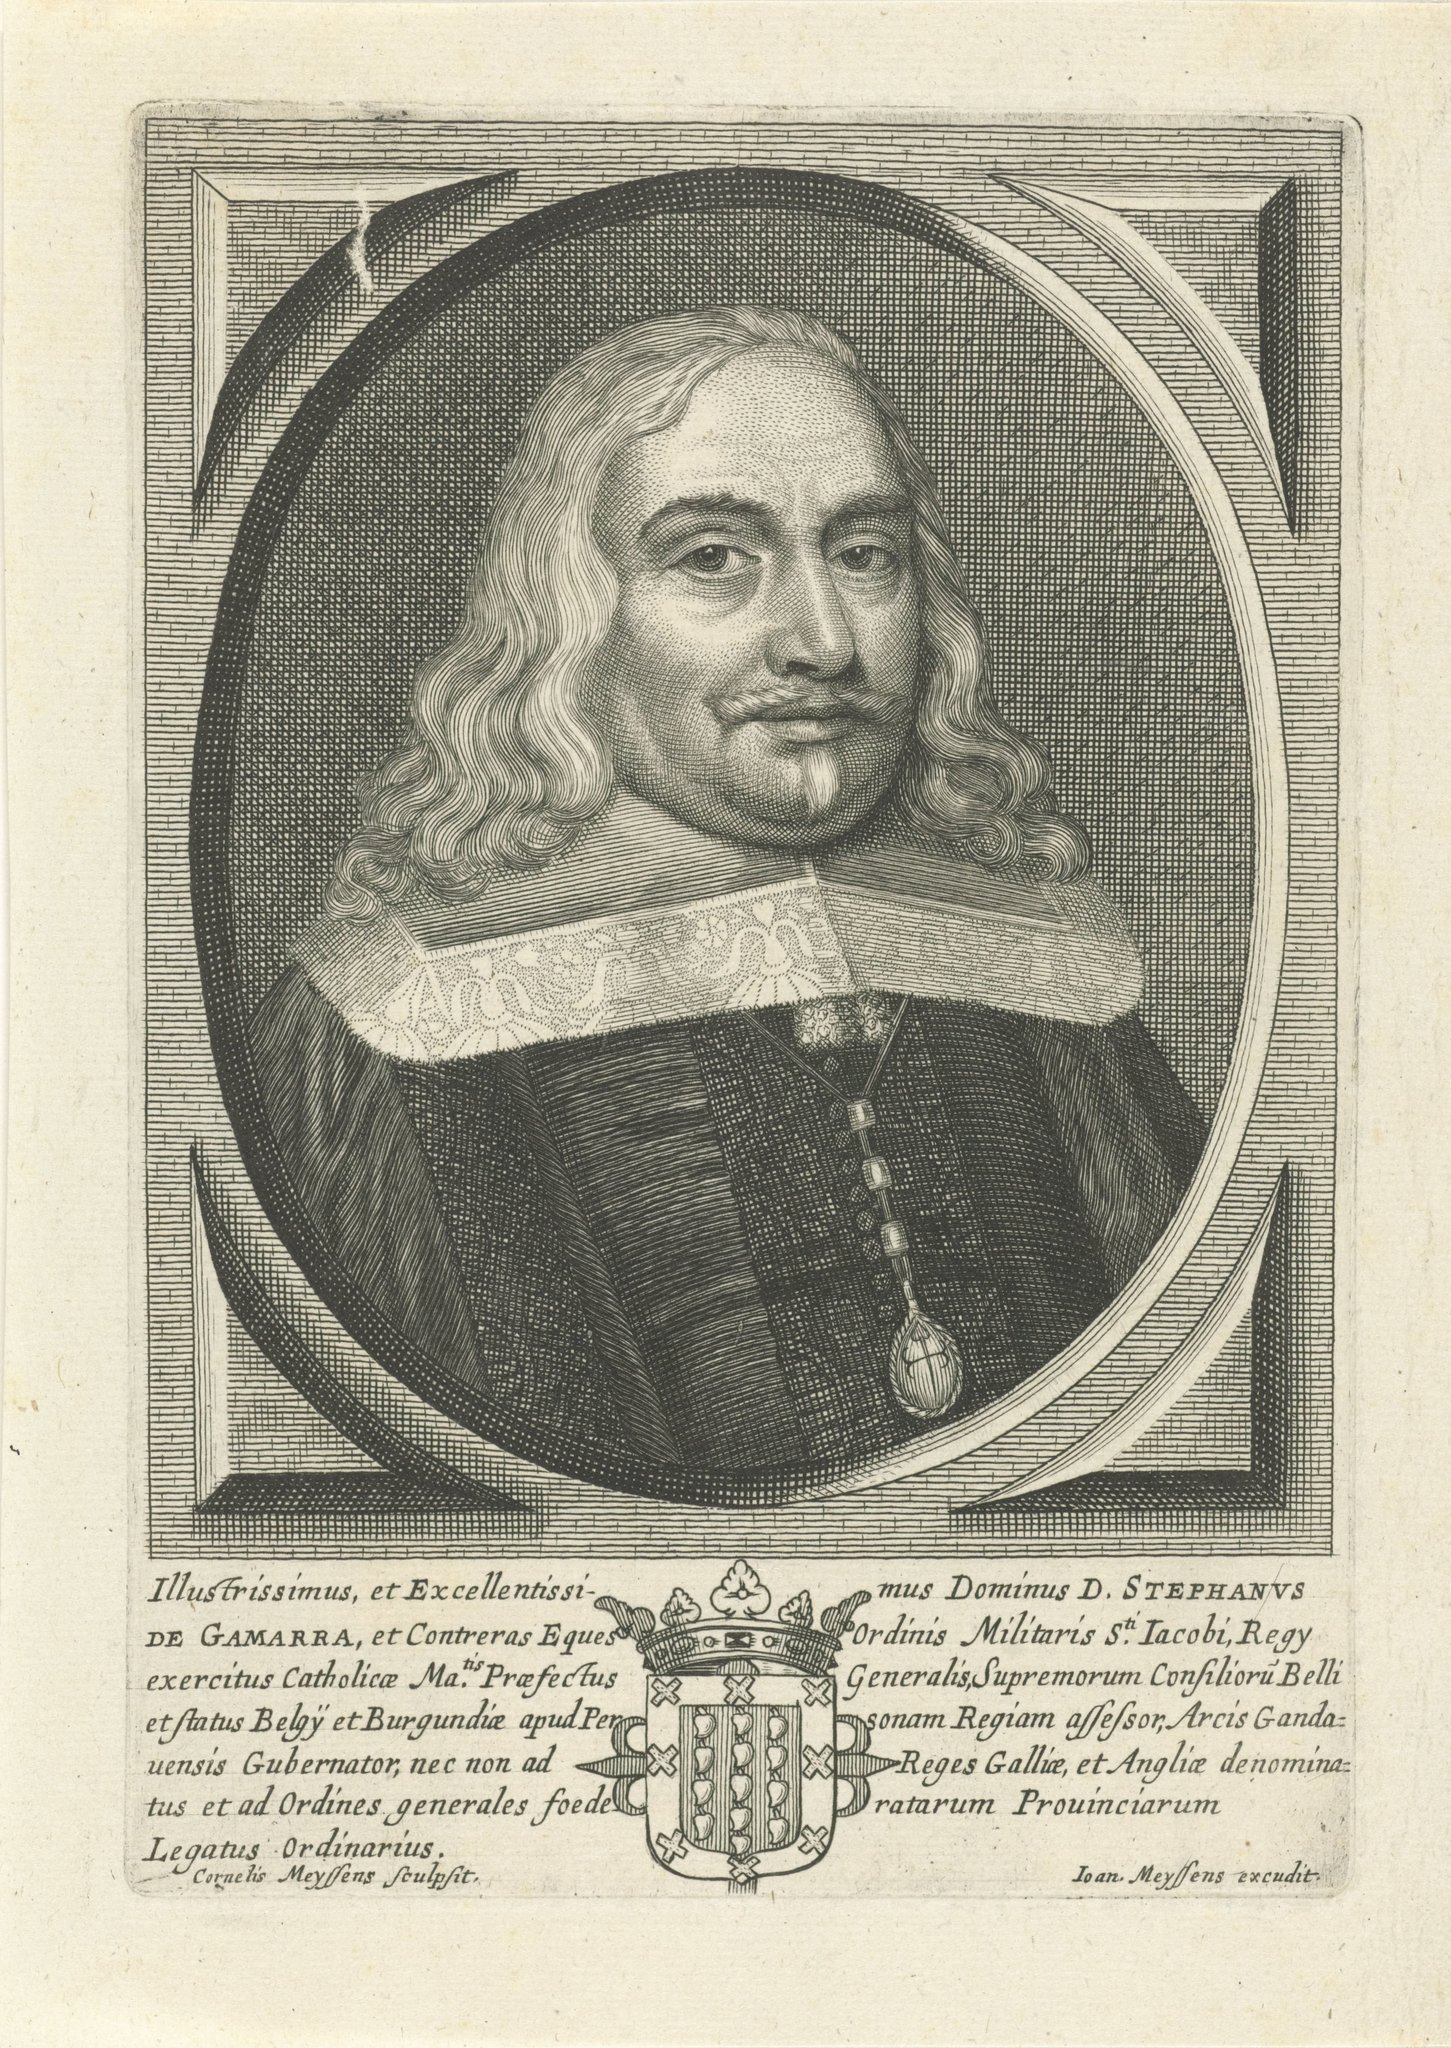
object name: print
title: Portret van Esteban de Gamarra y Contreras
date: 1650-1670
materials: paper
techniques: engraving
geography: antwerp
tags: brussels, the hague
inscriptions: collector's mark: Lugt 2228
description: Portret van Esteban de Gamarra y Contreras. Midden onder in de marge zijn wapenschild.